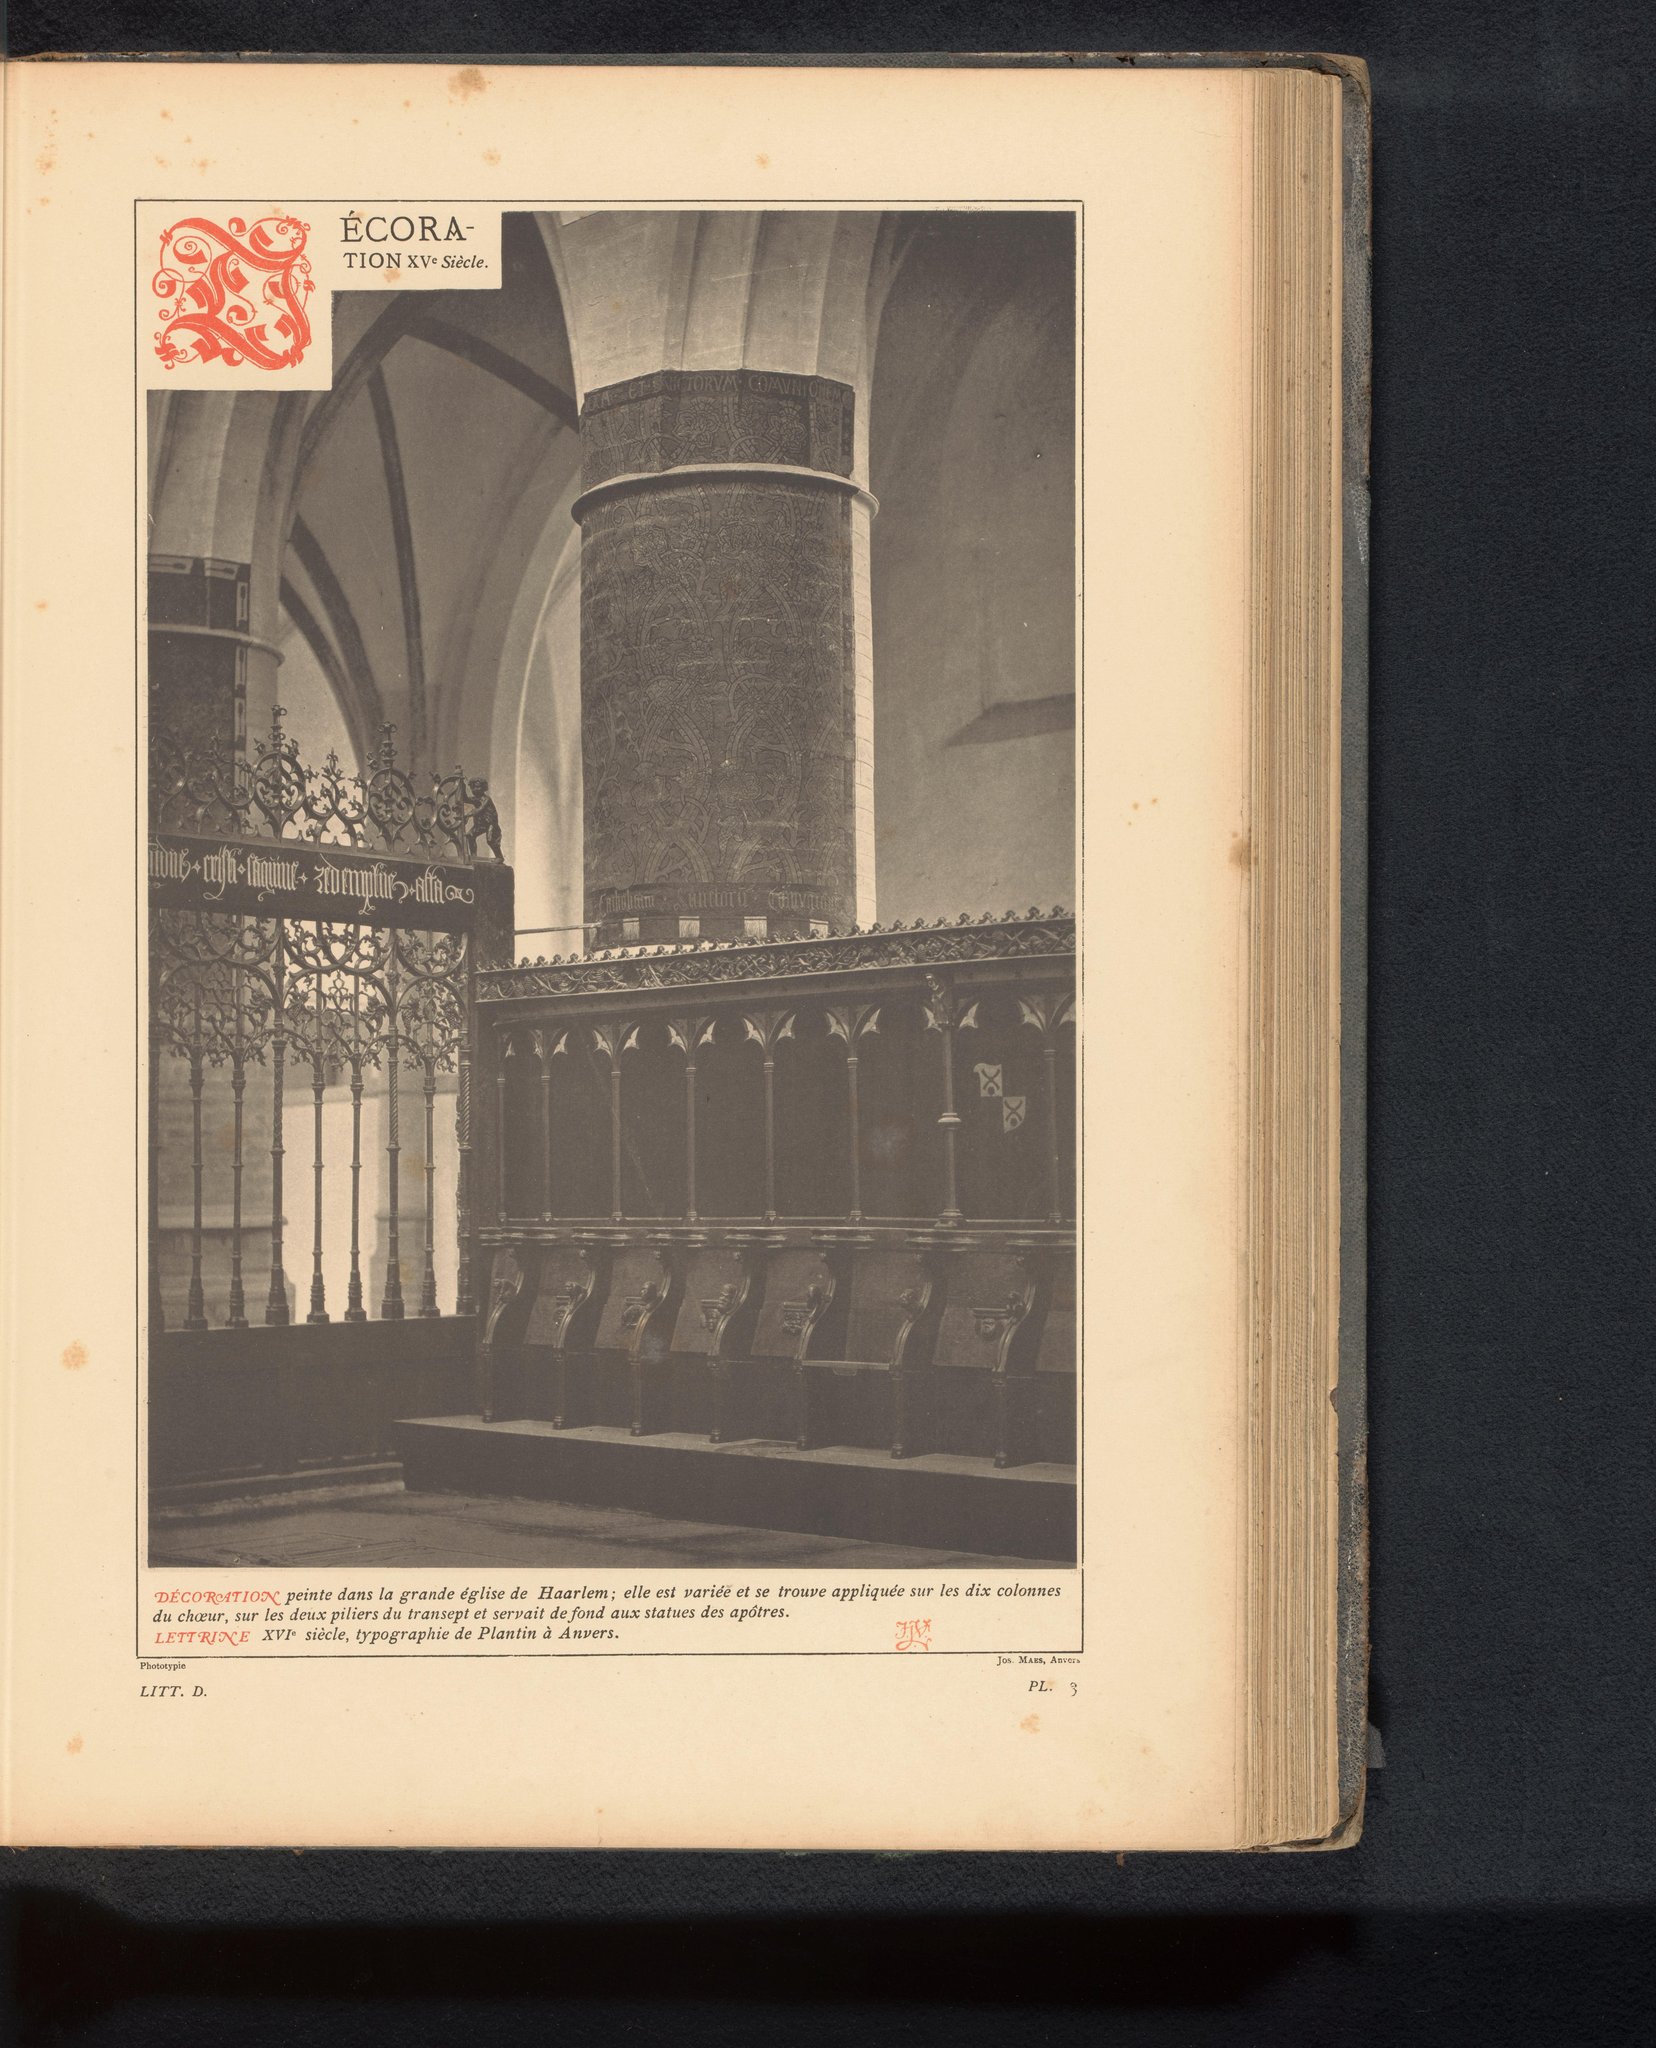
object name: page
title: Décoration, XVe Siècle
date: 1875-1880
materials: paper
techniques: photograph, photolithography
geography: antwerp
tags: interior of church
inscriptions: inscription: ‘Décoration peinte dans (...)’, inscription: ‘LITT. D. - PL. 3’, monogram: ‘JJvY’